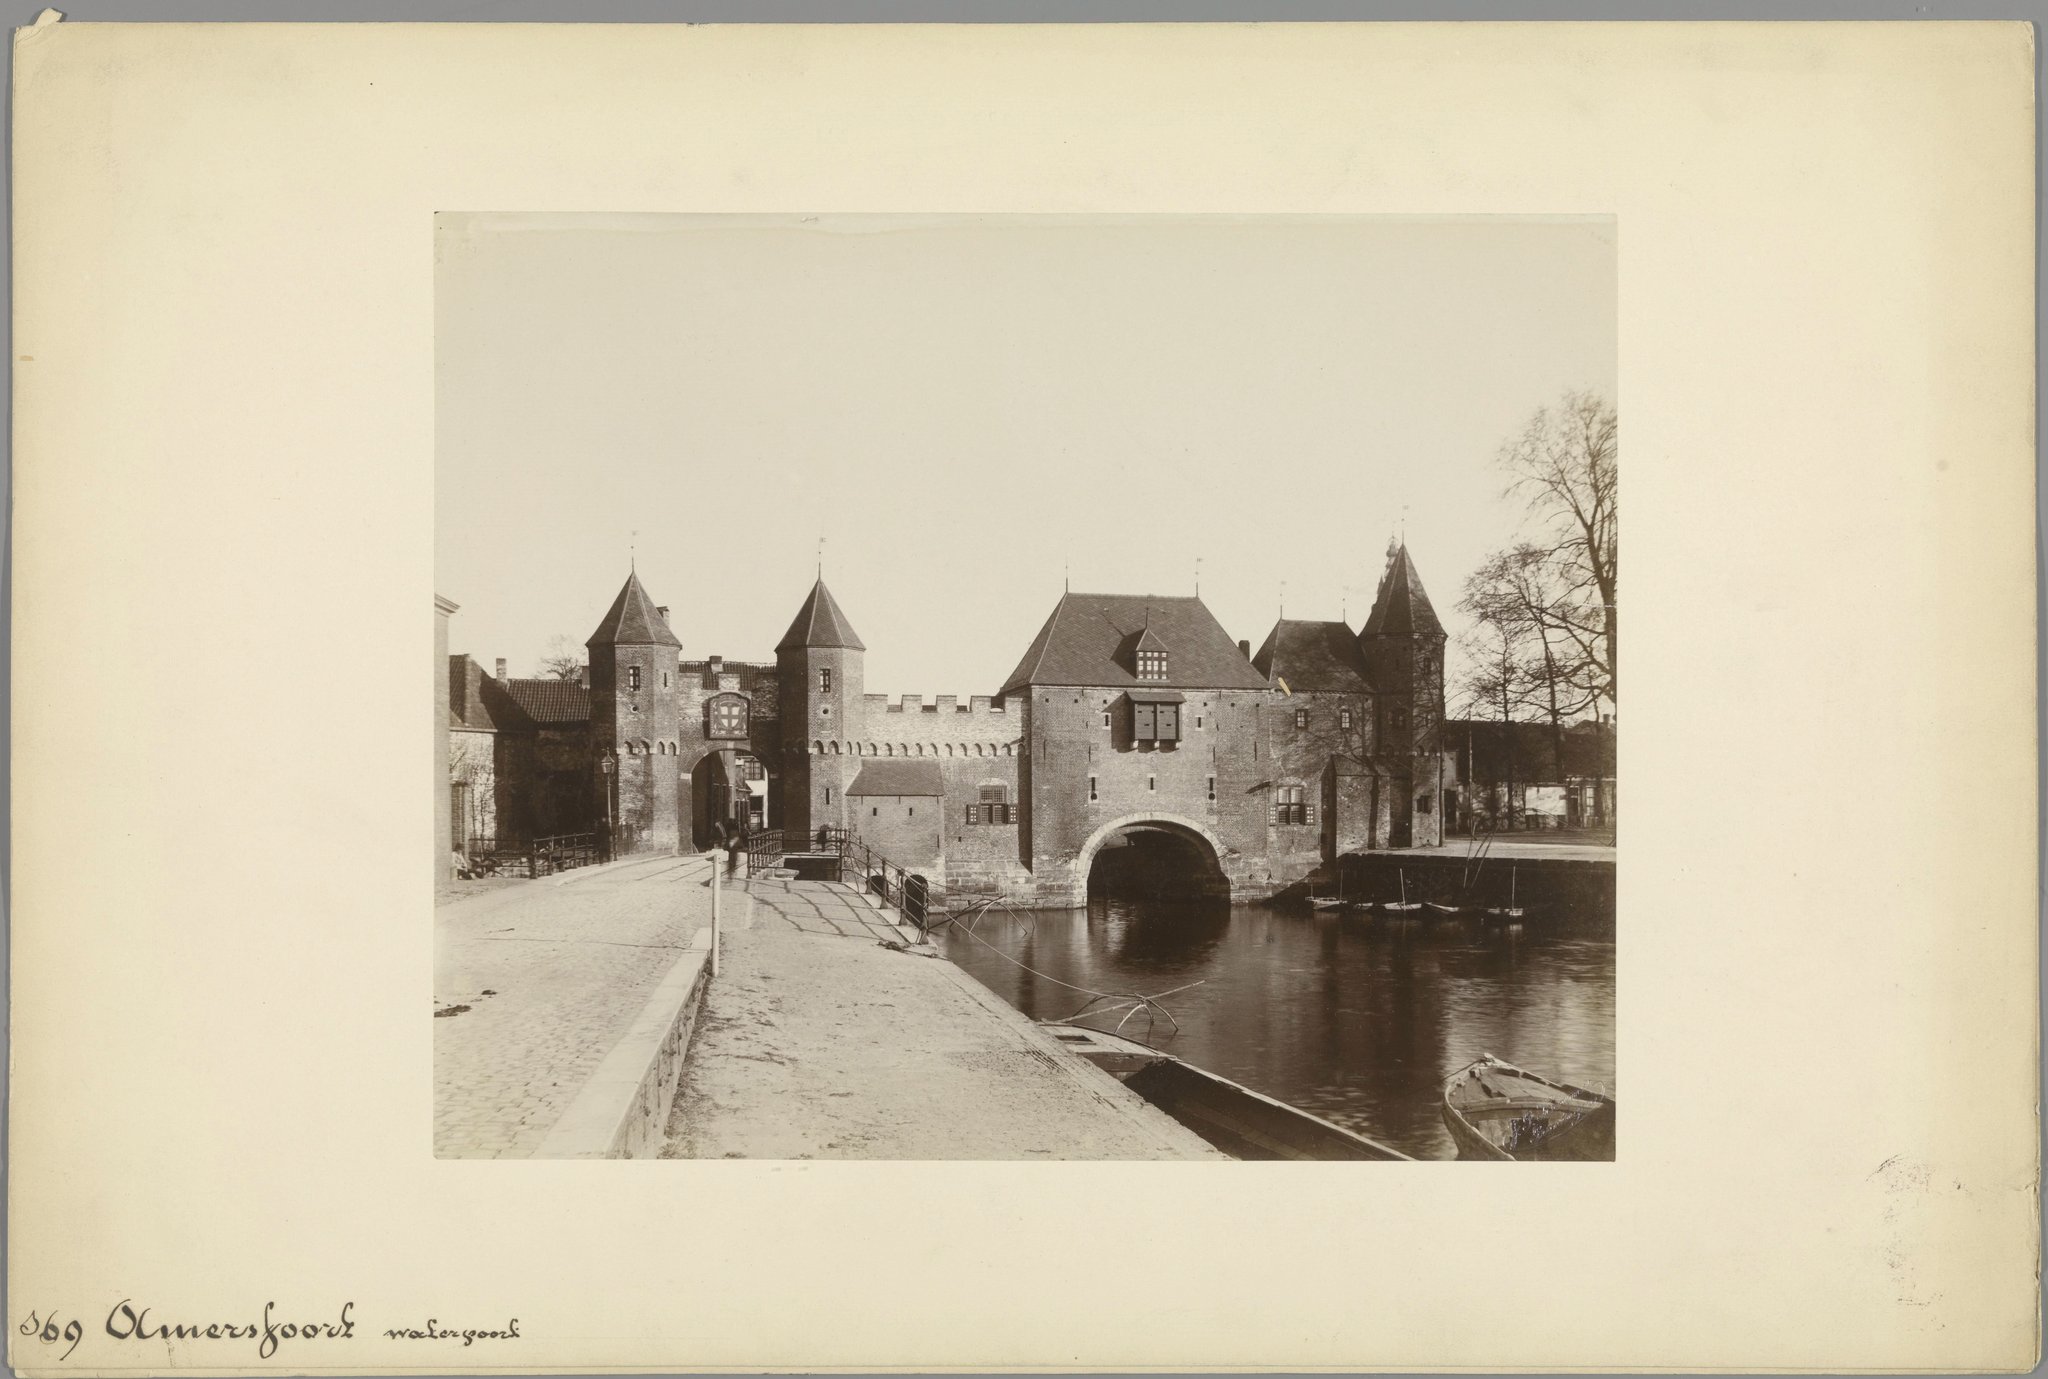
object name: photograph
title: Amersfoort waterpoort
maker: johannes gerardus kramer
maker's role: fotograaf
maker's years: 1845-1903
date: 1885-1900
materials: cardboard, photographic support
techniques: albumen print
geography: amersfoort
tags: towers ~ fortified city, canals, waters (in city), city-gate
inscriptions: number: ‘[...]69’, name: ‘J.G. Kramer Groningen’, collector's mark: Lugt 3937